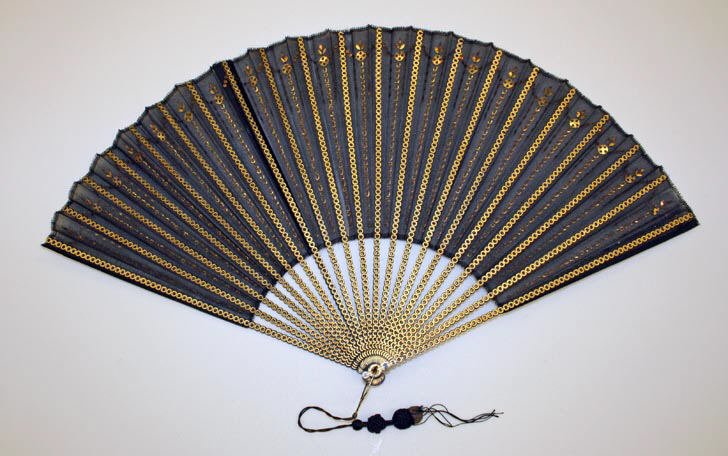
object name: fan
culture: french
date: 1890